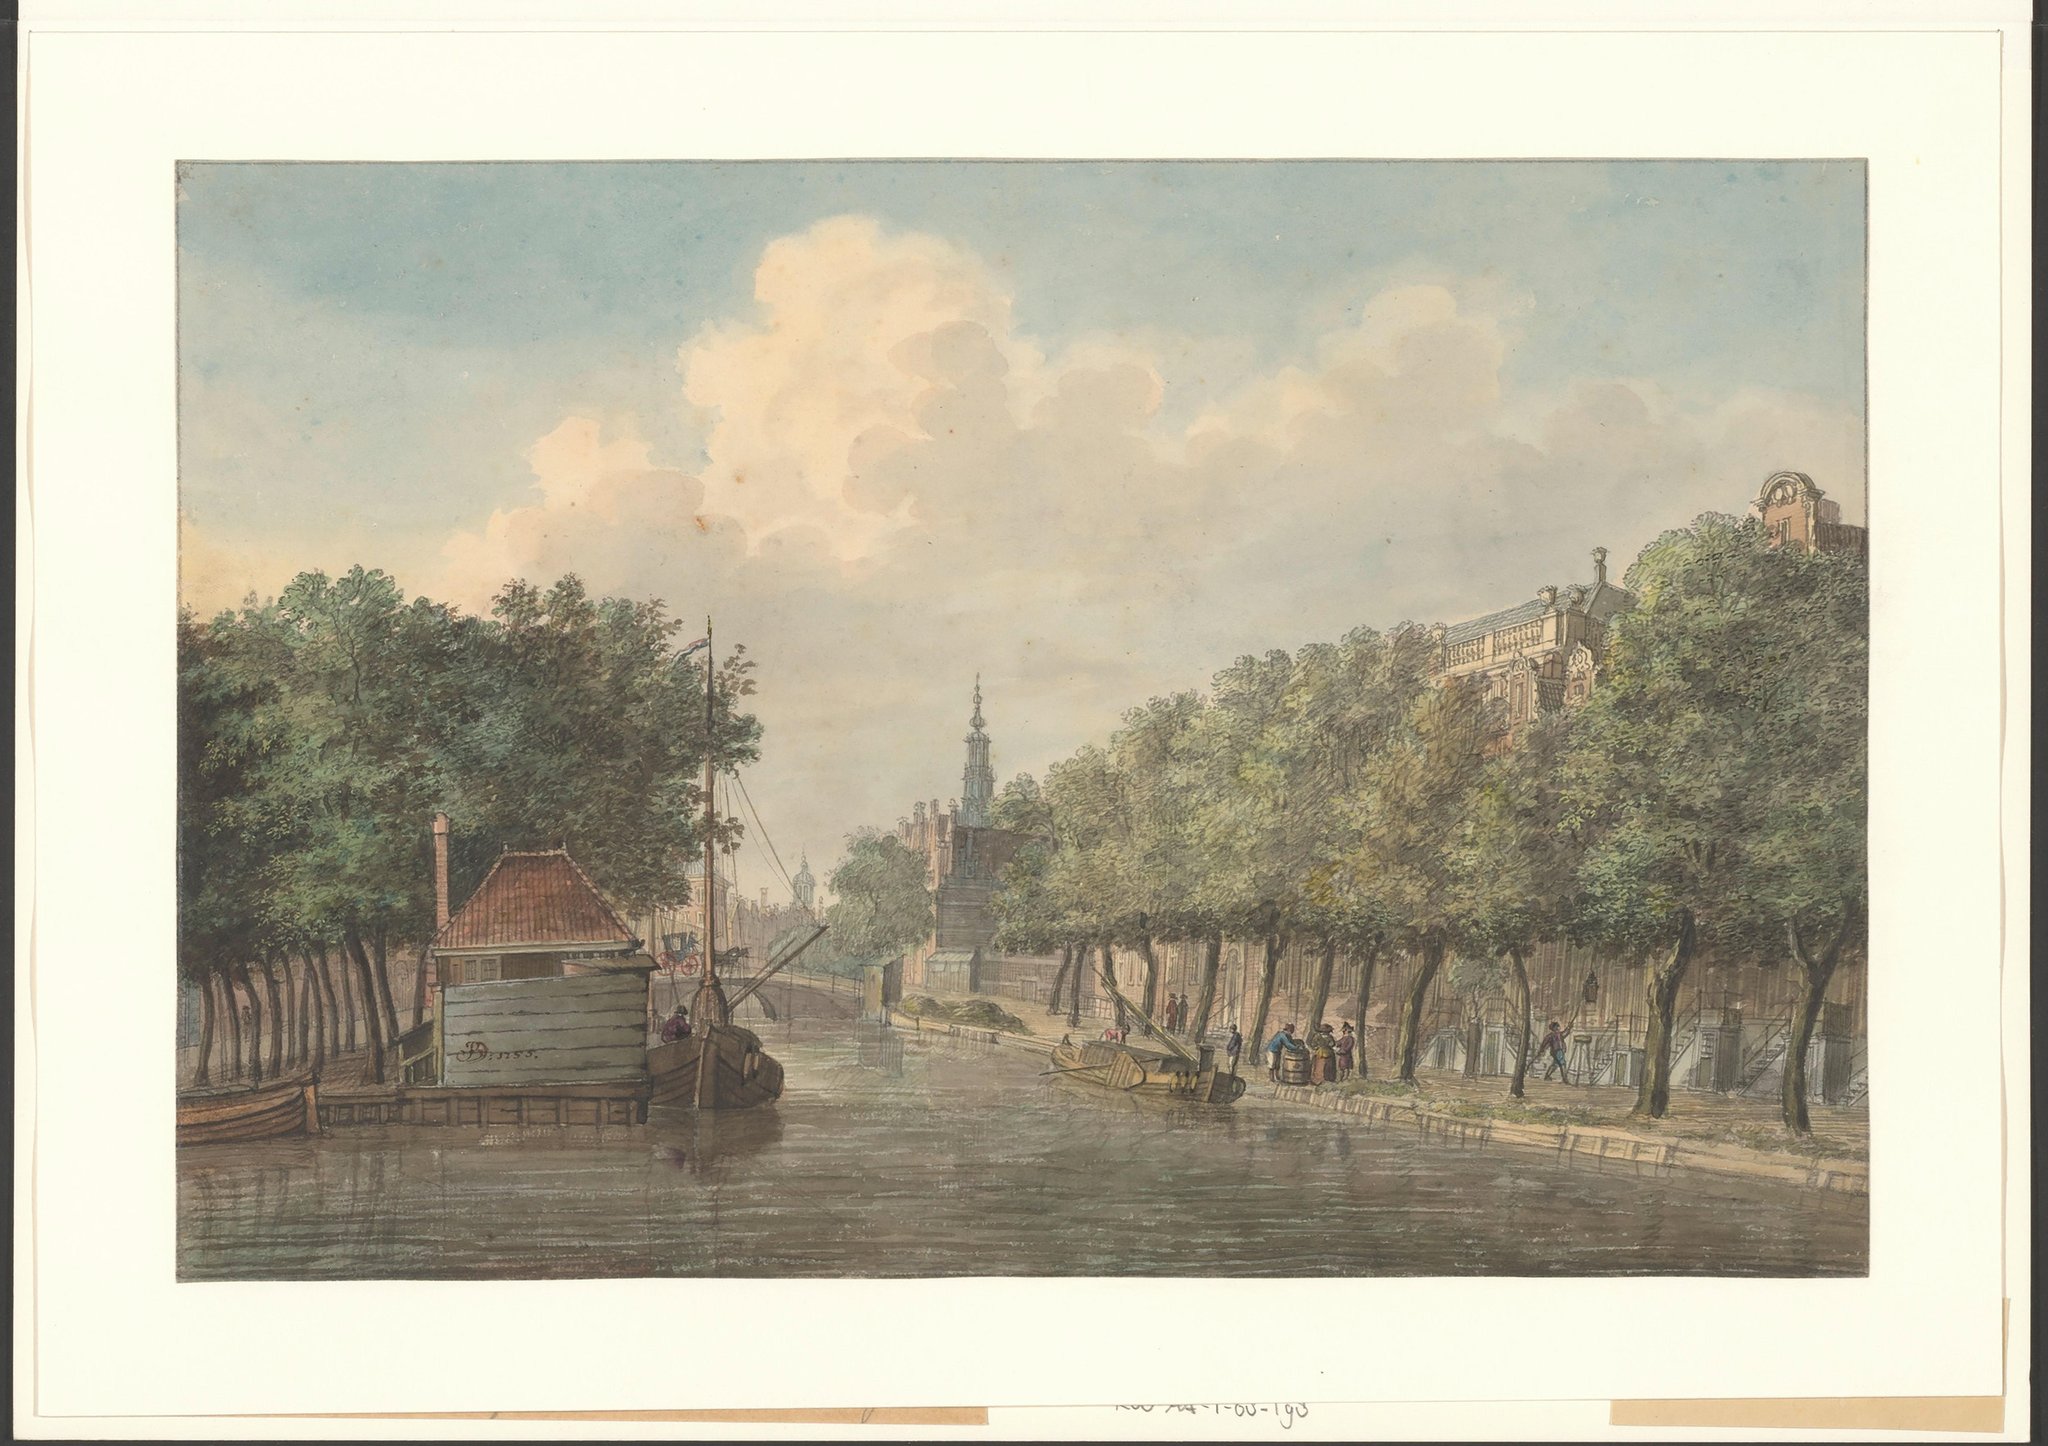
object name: drawing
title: Gezicht op de Nieuwe Herengracht, hoek Muidergracht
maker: jan de beijer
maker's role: draughtsman, print maker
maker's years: 1703-1780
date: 1755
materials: ink, paper, pencil, watercolor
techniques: brush, pen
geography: amsterdam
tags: city-view in general; 'veduta', canal, parts of church exterior and annexes: spire, street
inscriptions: collector's mark: ‘8’ Lugt 1641b, inscription: ‘Port-8-198’, inscription: ‘Nw. Herengracht hoek Muidergracht / Jode kerk door J de Beyer / en J Schouten’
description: Onderwerpsrubriek binnen de Atlas Amsterdam: Heerengracht (Nieuwe), Heiligeweg, Heisteeg, Heintjehoeksteeg, Hekelveld, Hemelrijk, Hoedemakerspad, Hol (‘t), Houtgracht, Houtewaelerboom, Houtkoopersdwarsstraat, Houttuinen (Joden), Houttuinen (Haarlemmer), Hugo de Grootkade, Huidenstraat, Huidenvetterstraat, Huydecoperstraat.